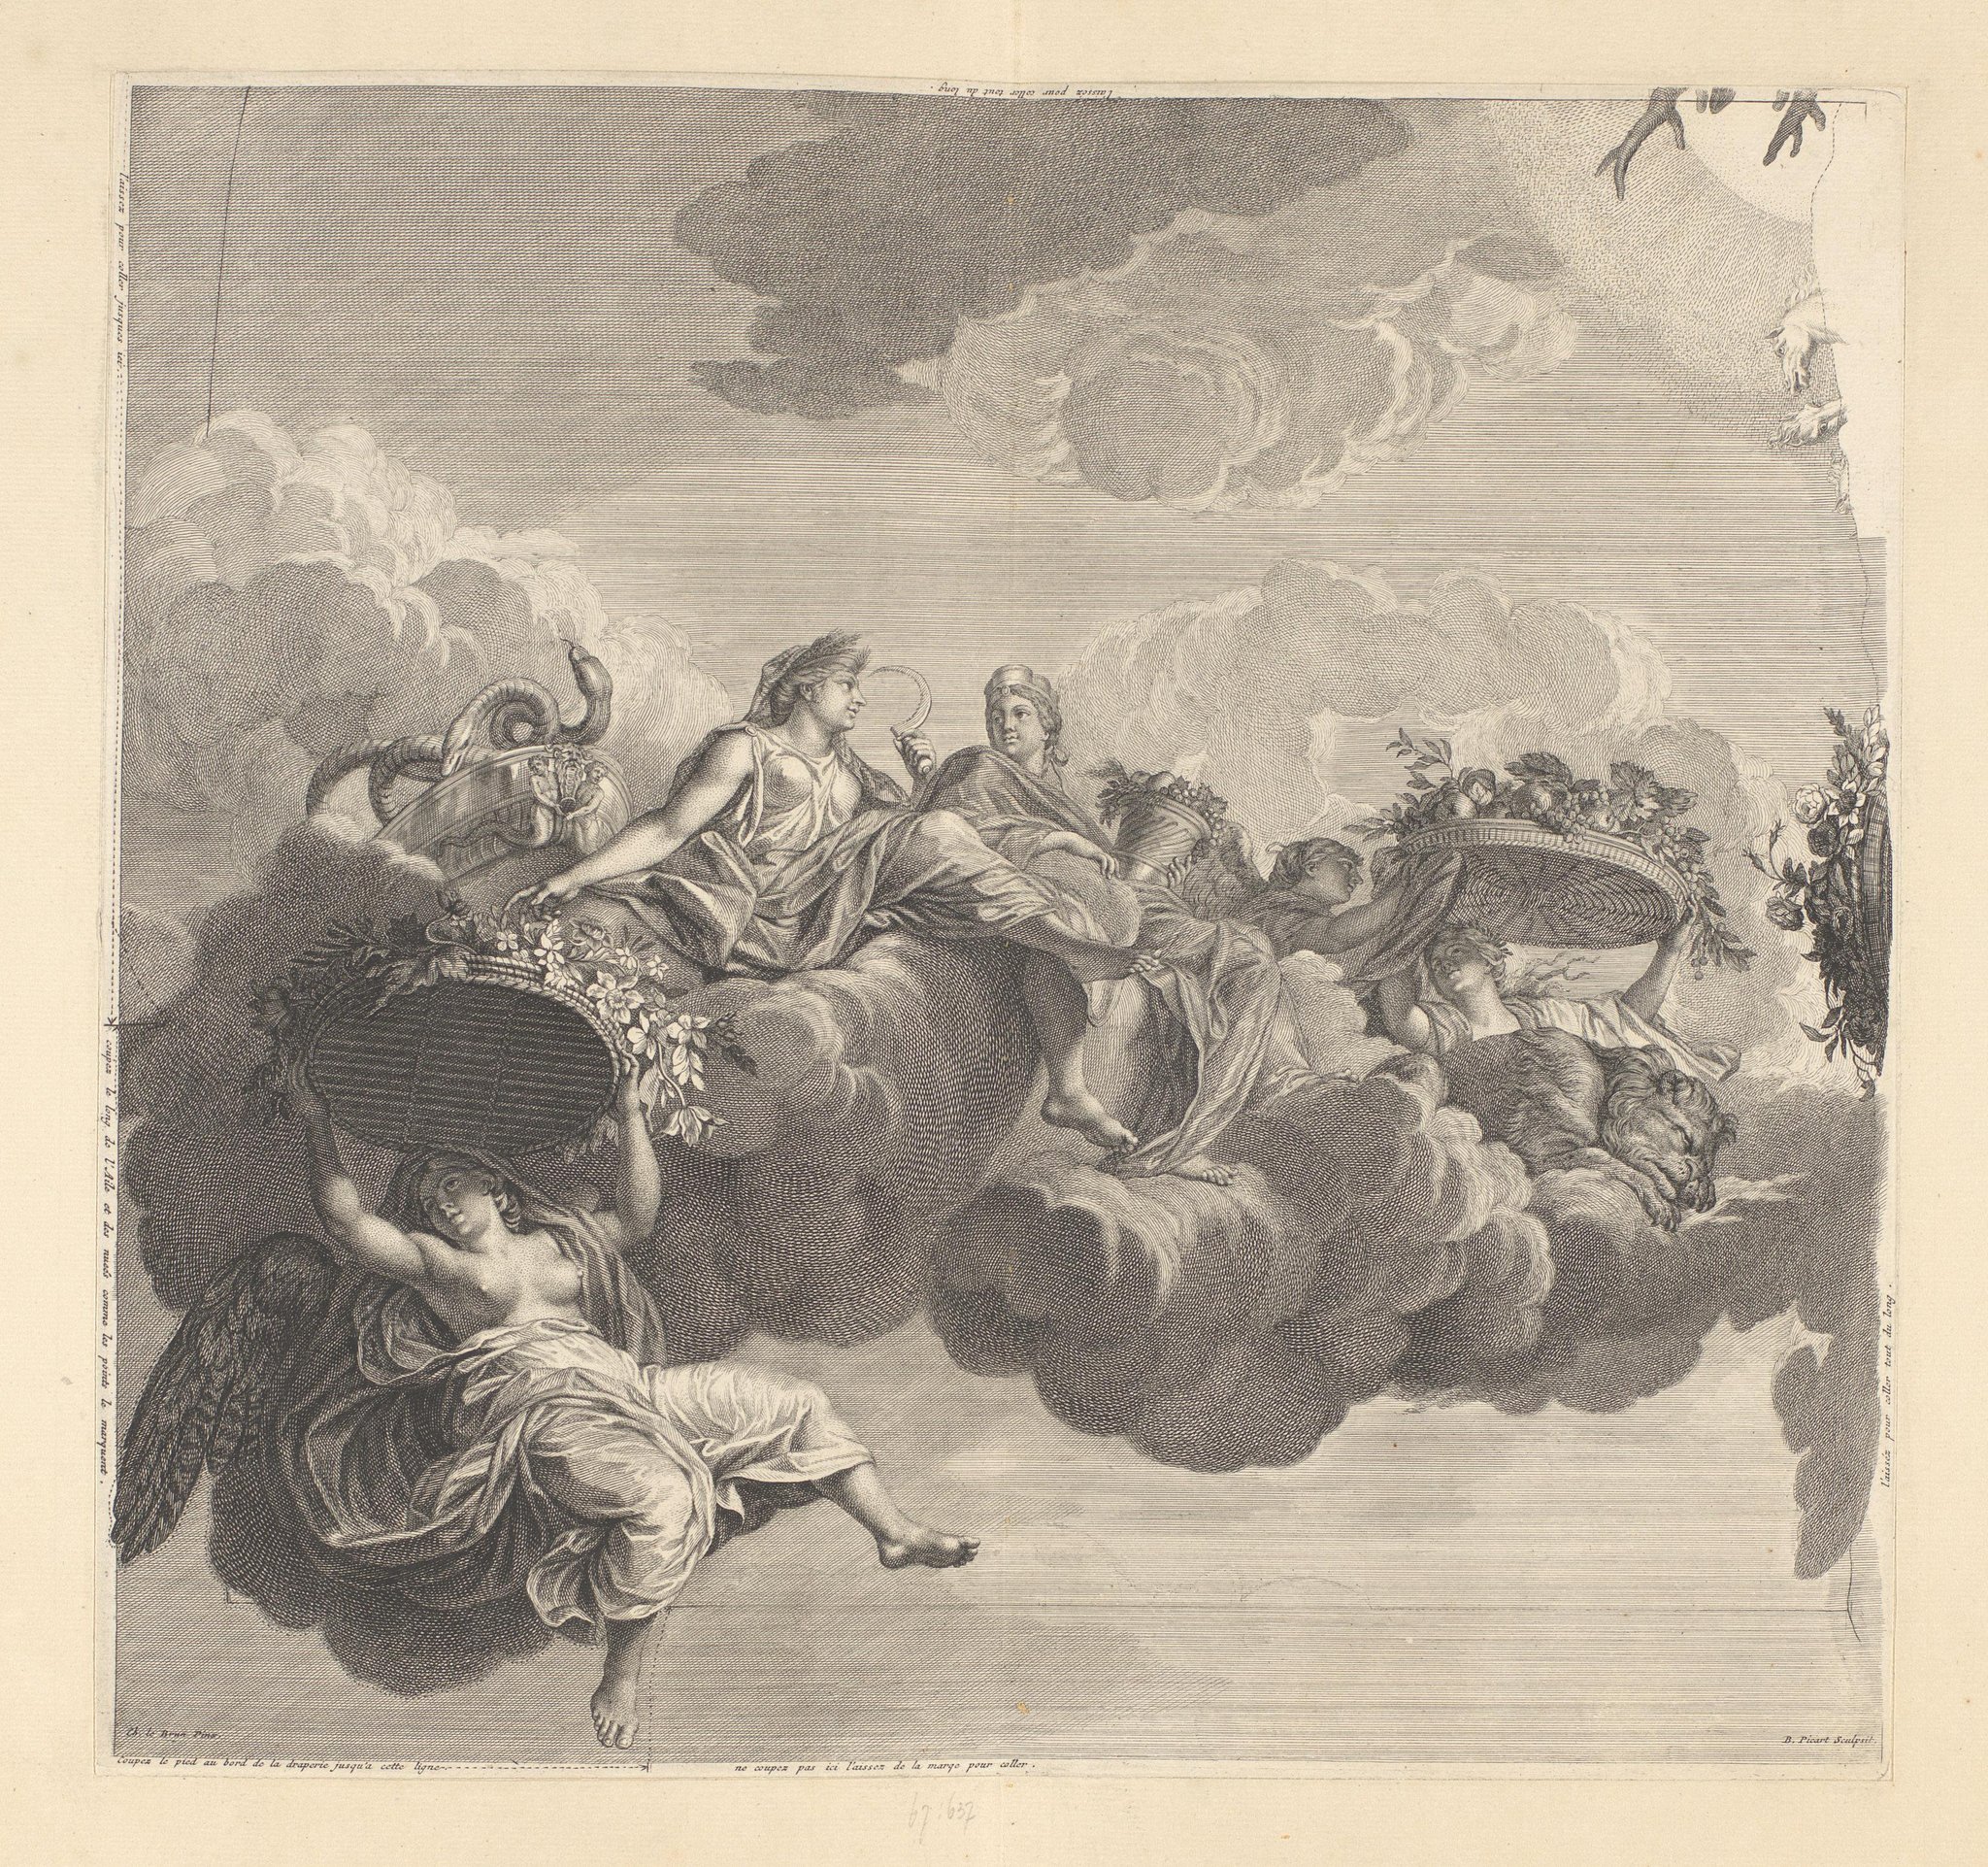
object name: print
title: L'ouvrage de Charles le Brun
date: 1710-1720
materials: paper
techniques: engraving, etching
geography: amsterdam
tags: hercules and hebe, (decorated) ceiling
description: Ceres, Cybele en de volgelingen van Flora op de wolken. Zij bereiden het huwelijksfeest voor van Hercules en Hebe. Langs de randen instructies voor het monteren van de prent aan andere prenten. Prent maakt deel uit van een serie prenten, die samen het geschilderde plafond met de Apotheose van Hercules in het Hôtel Lambert te Parijs voorstellen. Deze prent maakt deel uit van een album.